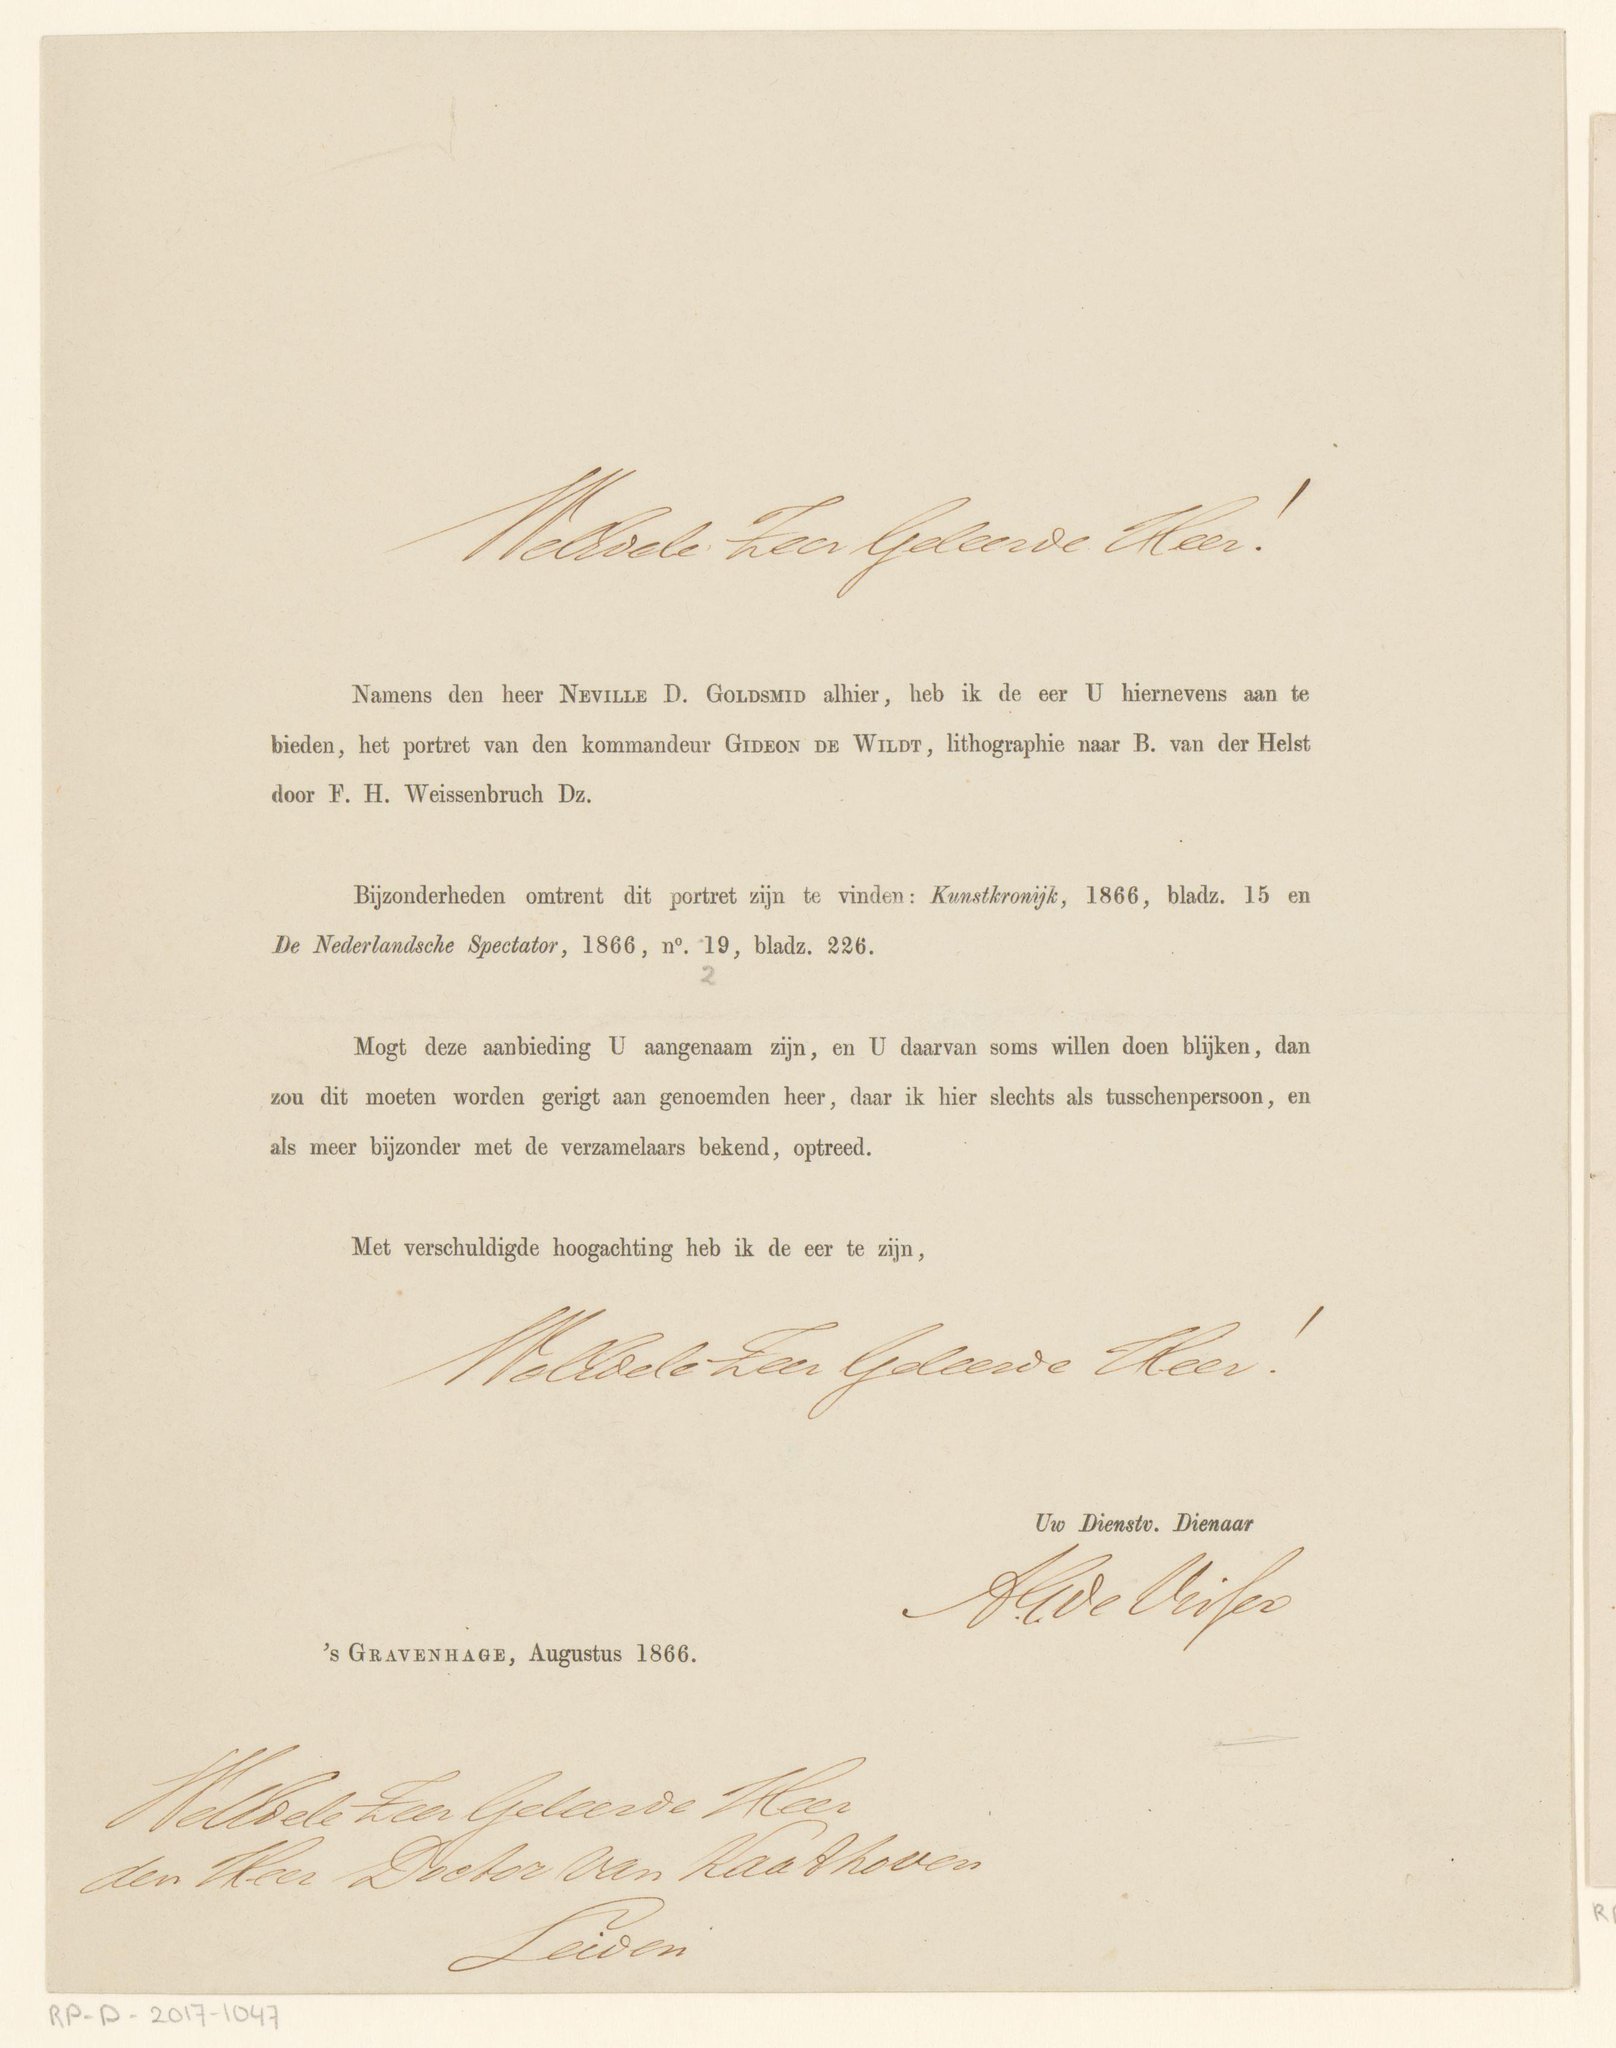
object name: letter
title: Brief aan meneer Kaathoven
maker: a.g. de visser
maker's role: schrijver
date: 1808-1866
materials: paper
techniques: letterpress printing, writing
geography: netherlands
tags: historical persons (portraits and scenes from the life)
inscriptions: collector's mark: Lugt 2228